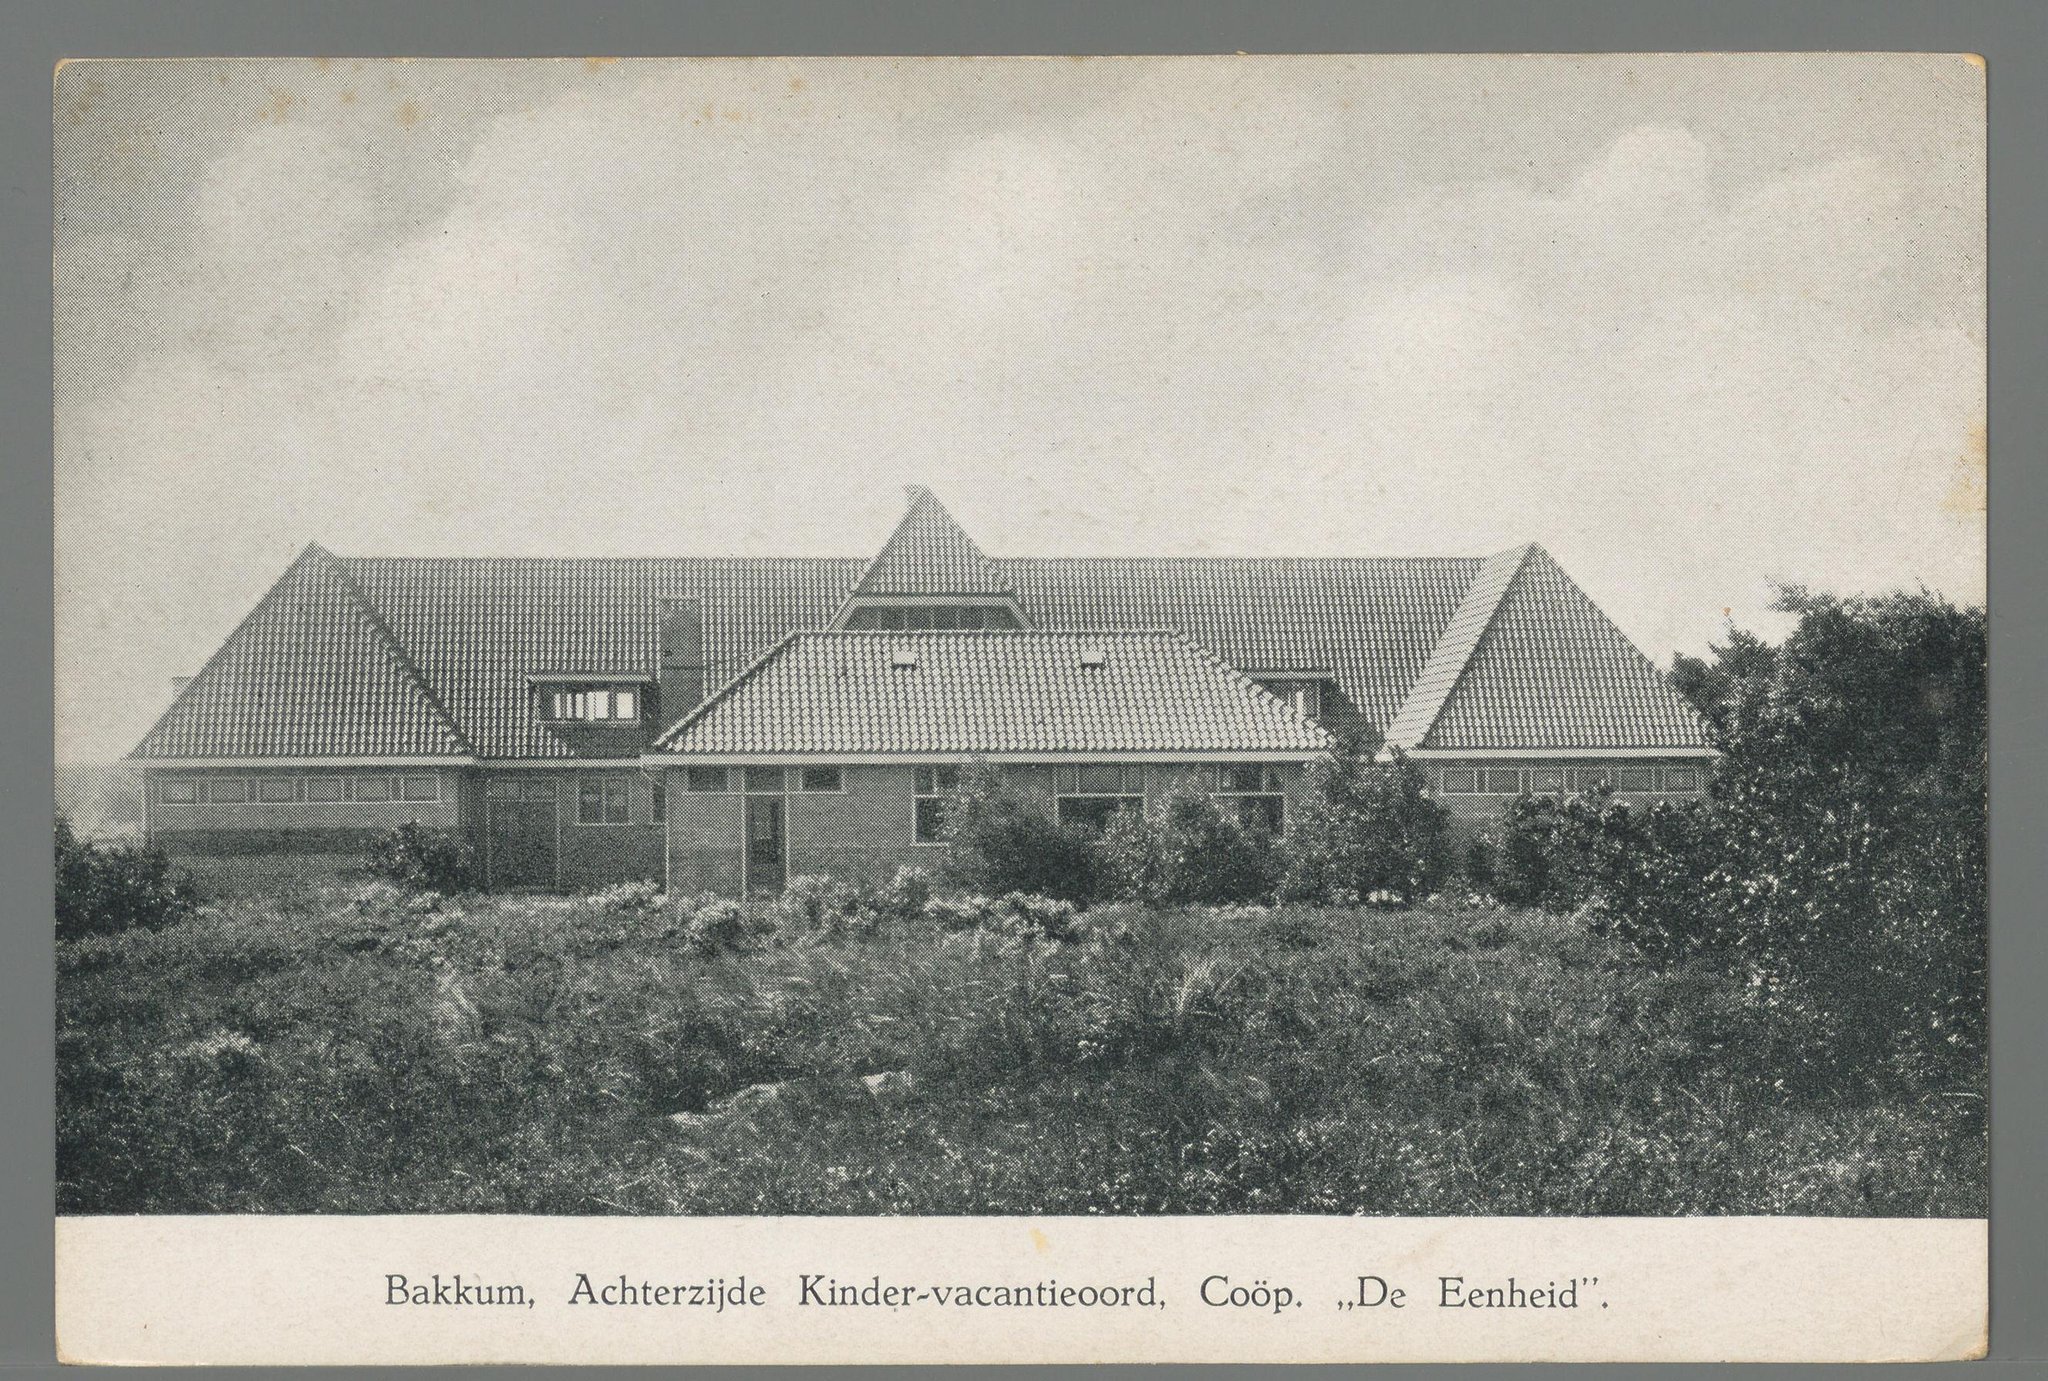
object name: ansichtkaart, prentbriefkaart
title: Bakkum, Achterzijde Kinder-vacantieoord, Coöp. "De Eenheid".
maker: Anonymous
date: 1932-1933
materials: cardboard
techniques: writing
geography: bakkum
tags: city-view, and landscape with man-made constructions, plants; vegetation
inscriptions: postage stamp